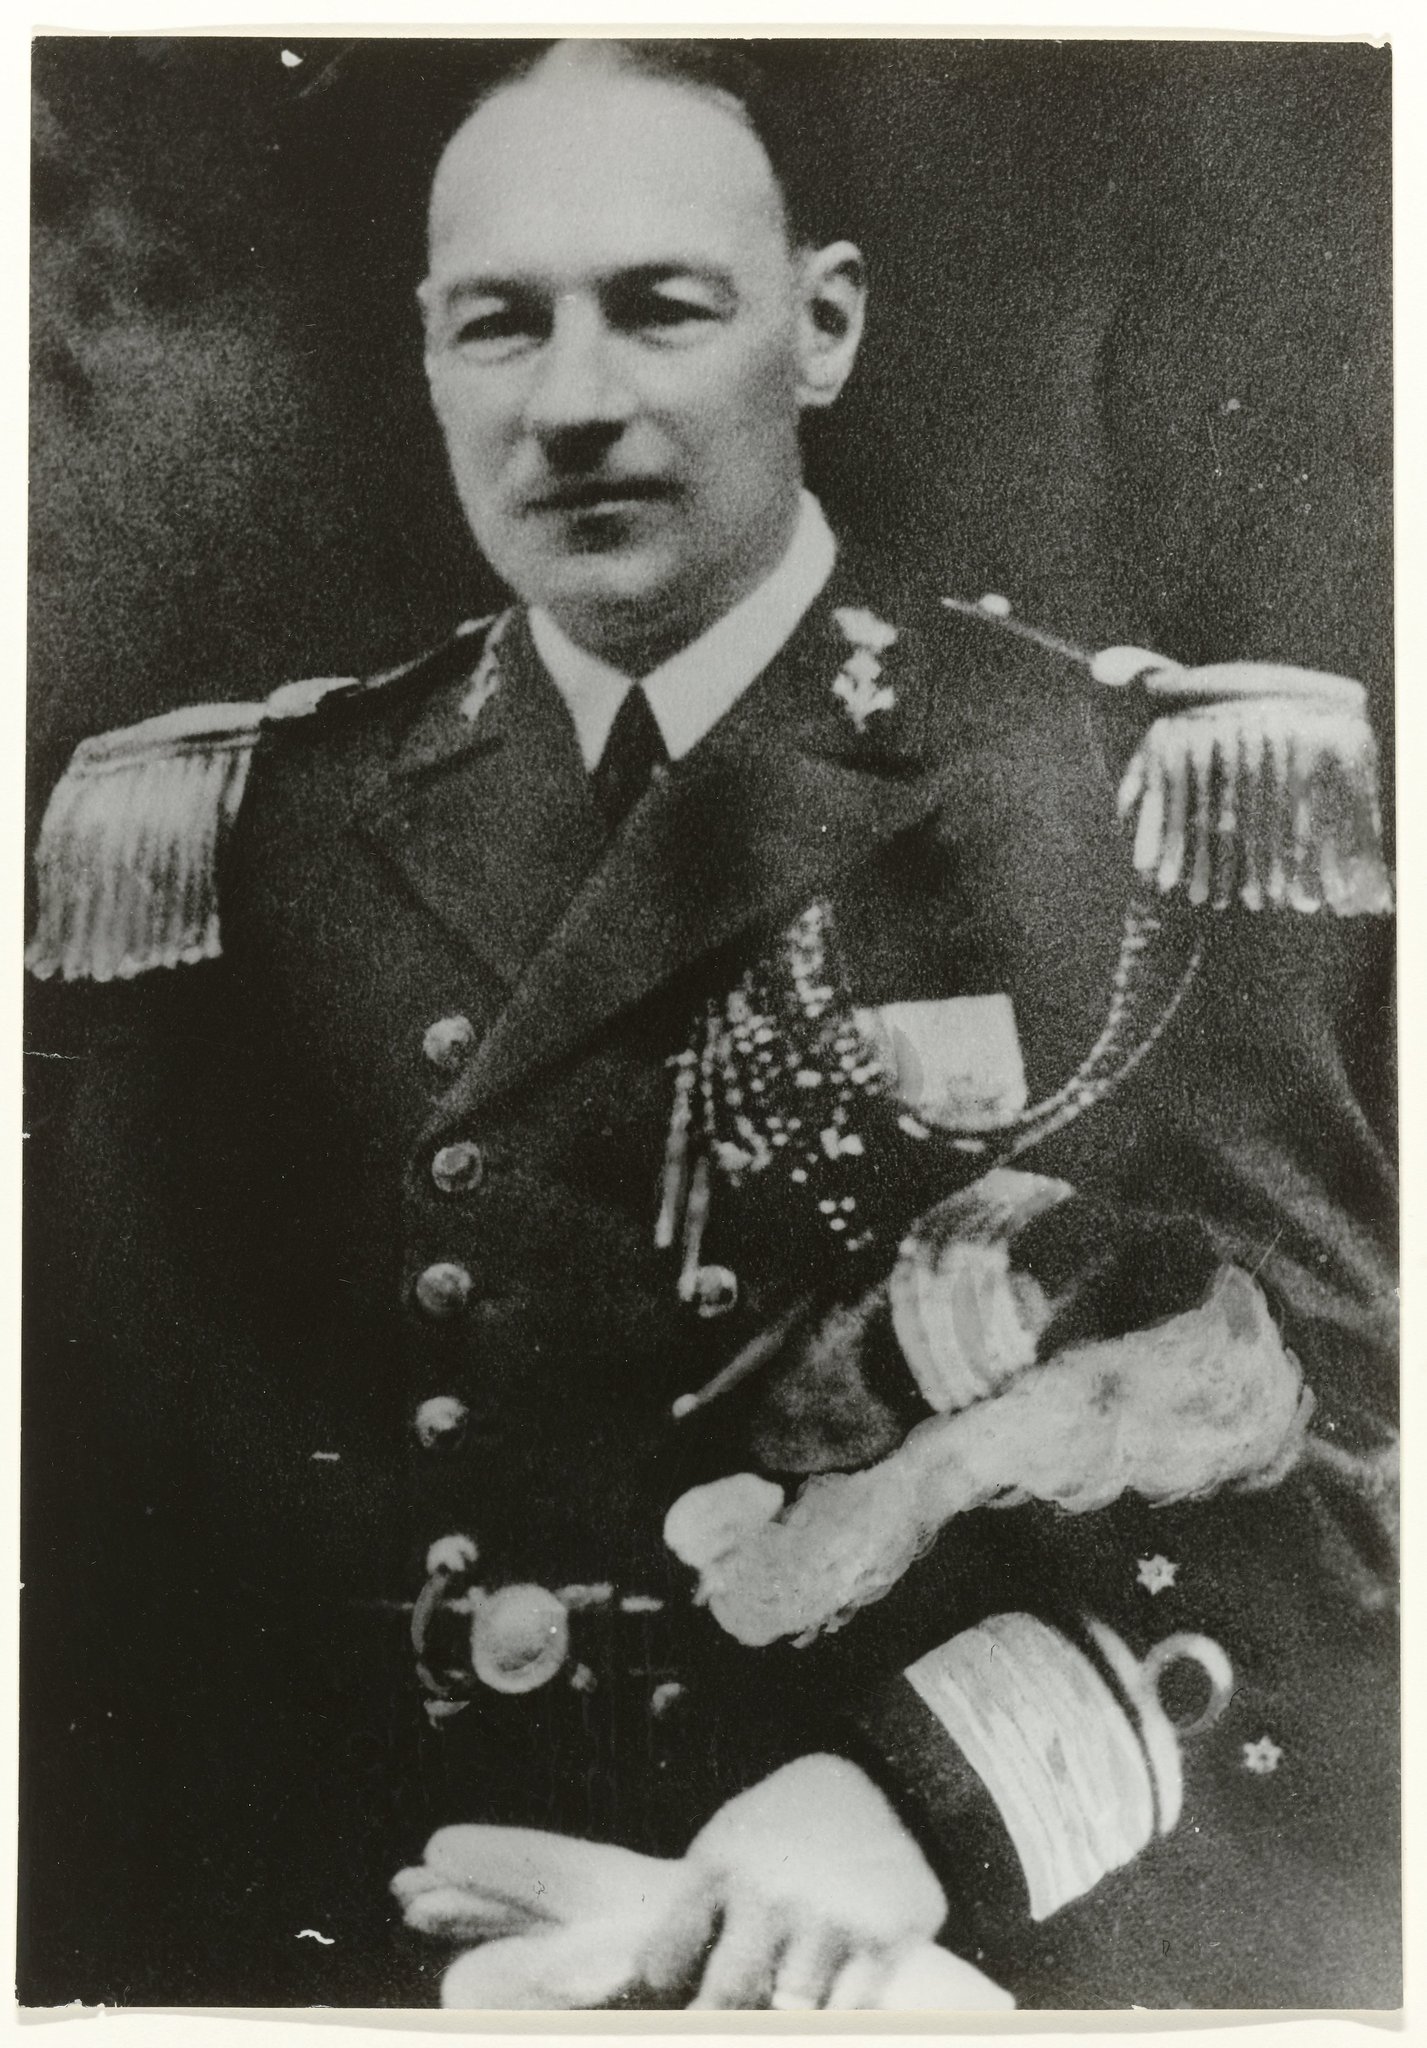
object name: photograph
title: Karel Doorman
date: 1910-1945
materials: photographic support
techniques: photography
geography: netherlands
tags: utrecht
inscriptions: stamp: ‘COPYRIGHT / 'ANEFO' / ALGEMEEN NEDERLANDSCH FOTOBUREAU’, inscription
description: Karel Doorman, bevelhebber van de vloot tijdens de Slag in de Javazee.